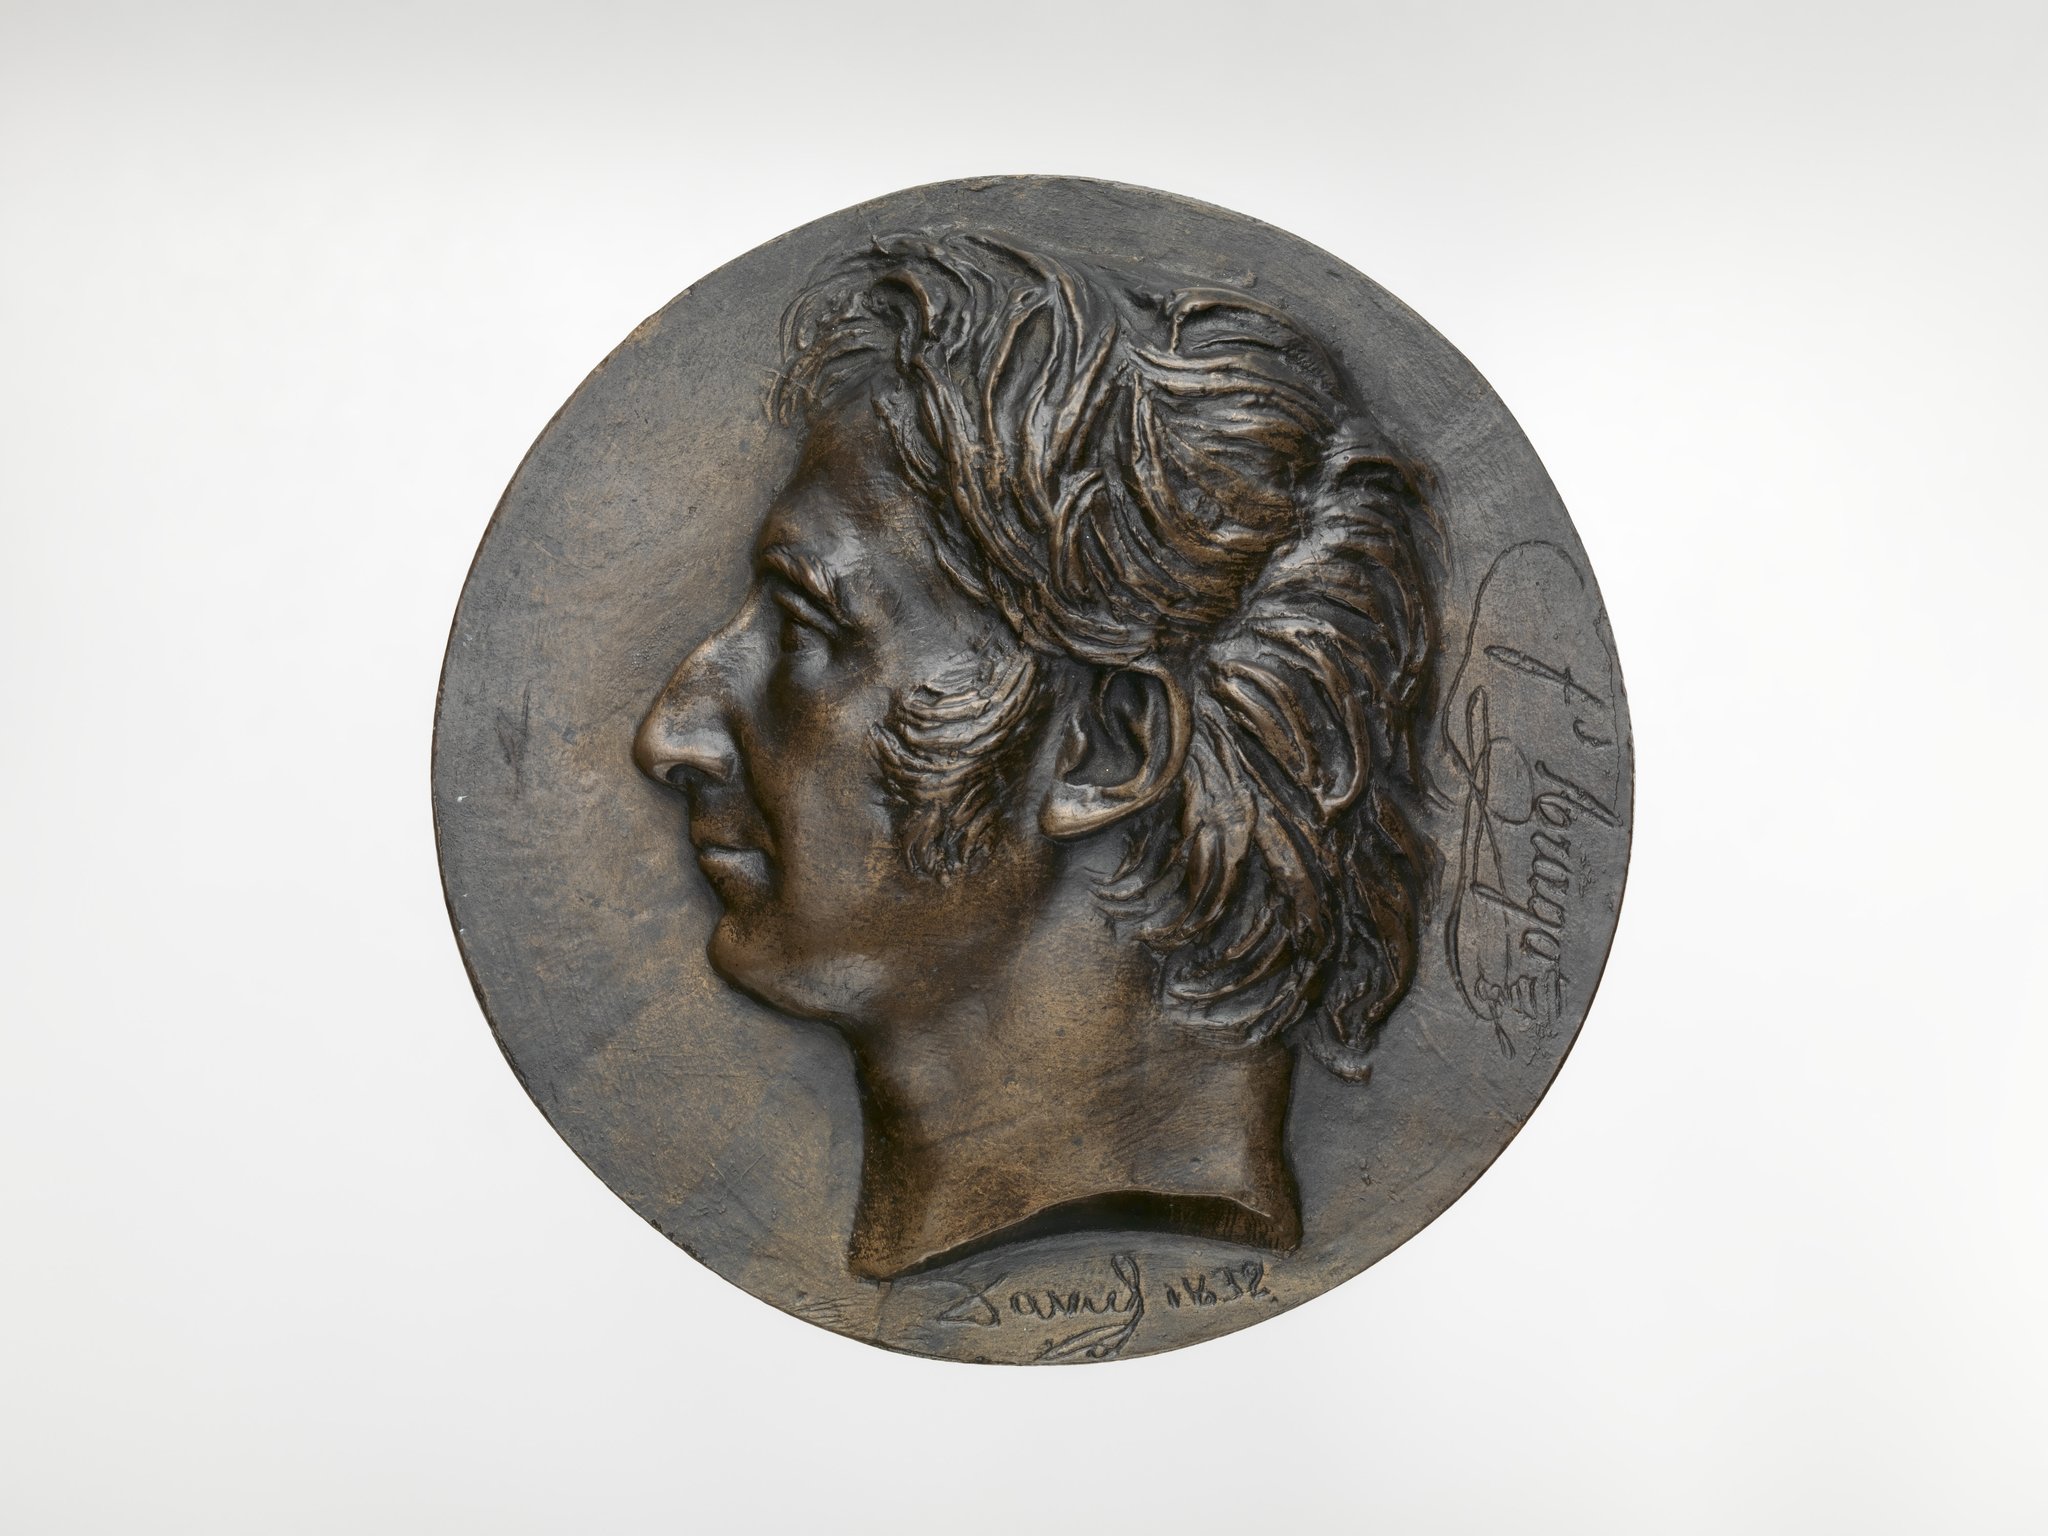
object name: medallion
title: Dominique François Arago (1786–1856)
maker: pierre jean david d'angers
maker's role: artist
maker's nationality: french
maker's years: 1788-1856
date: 1832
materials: bronze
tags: men,profiles